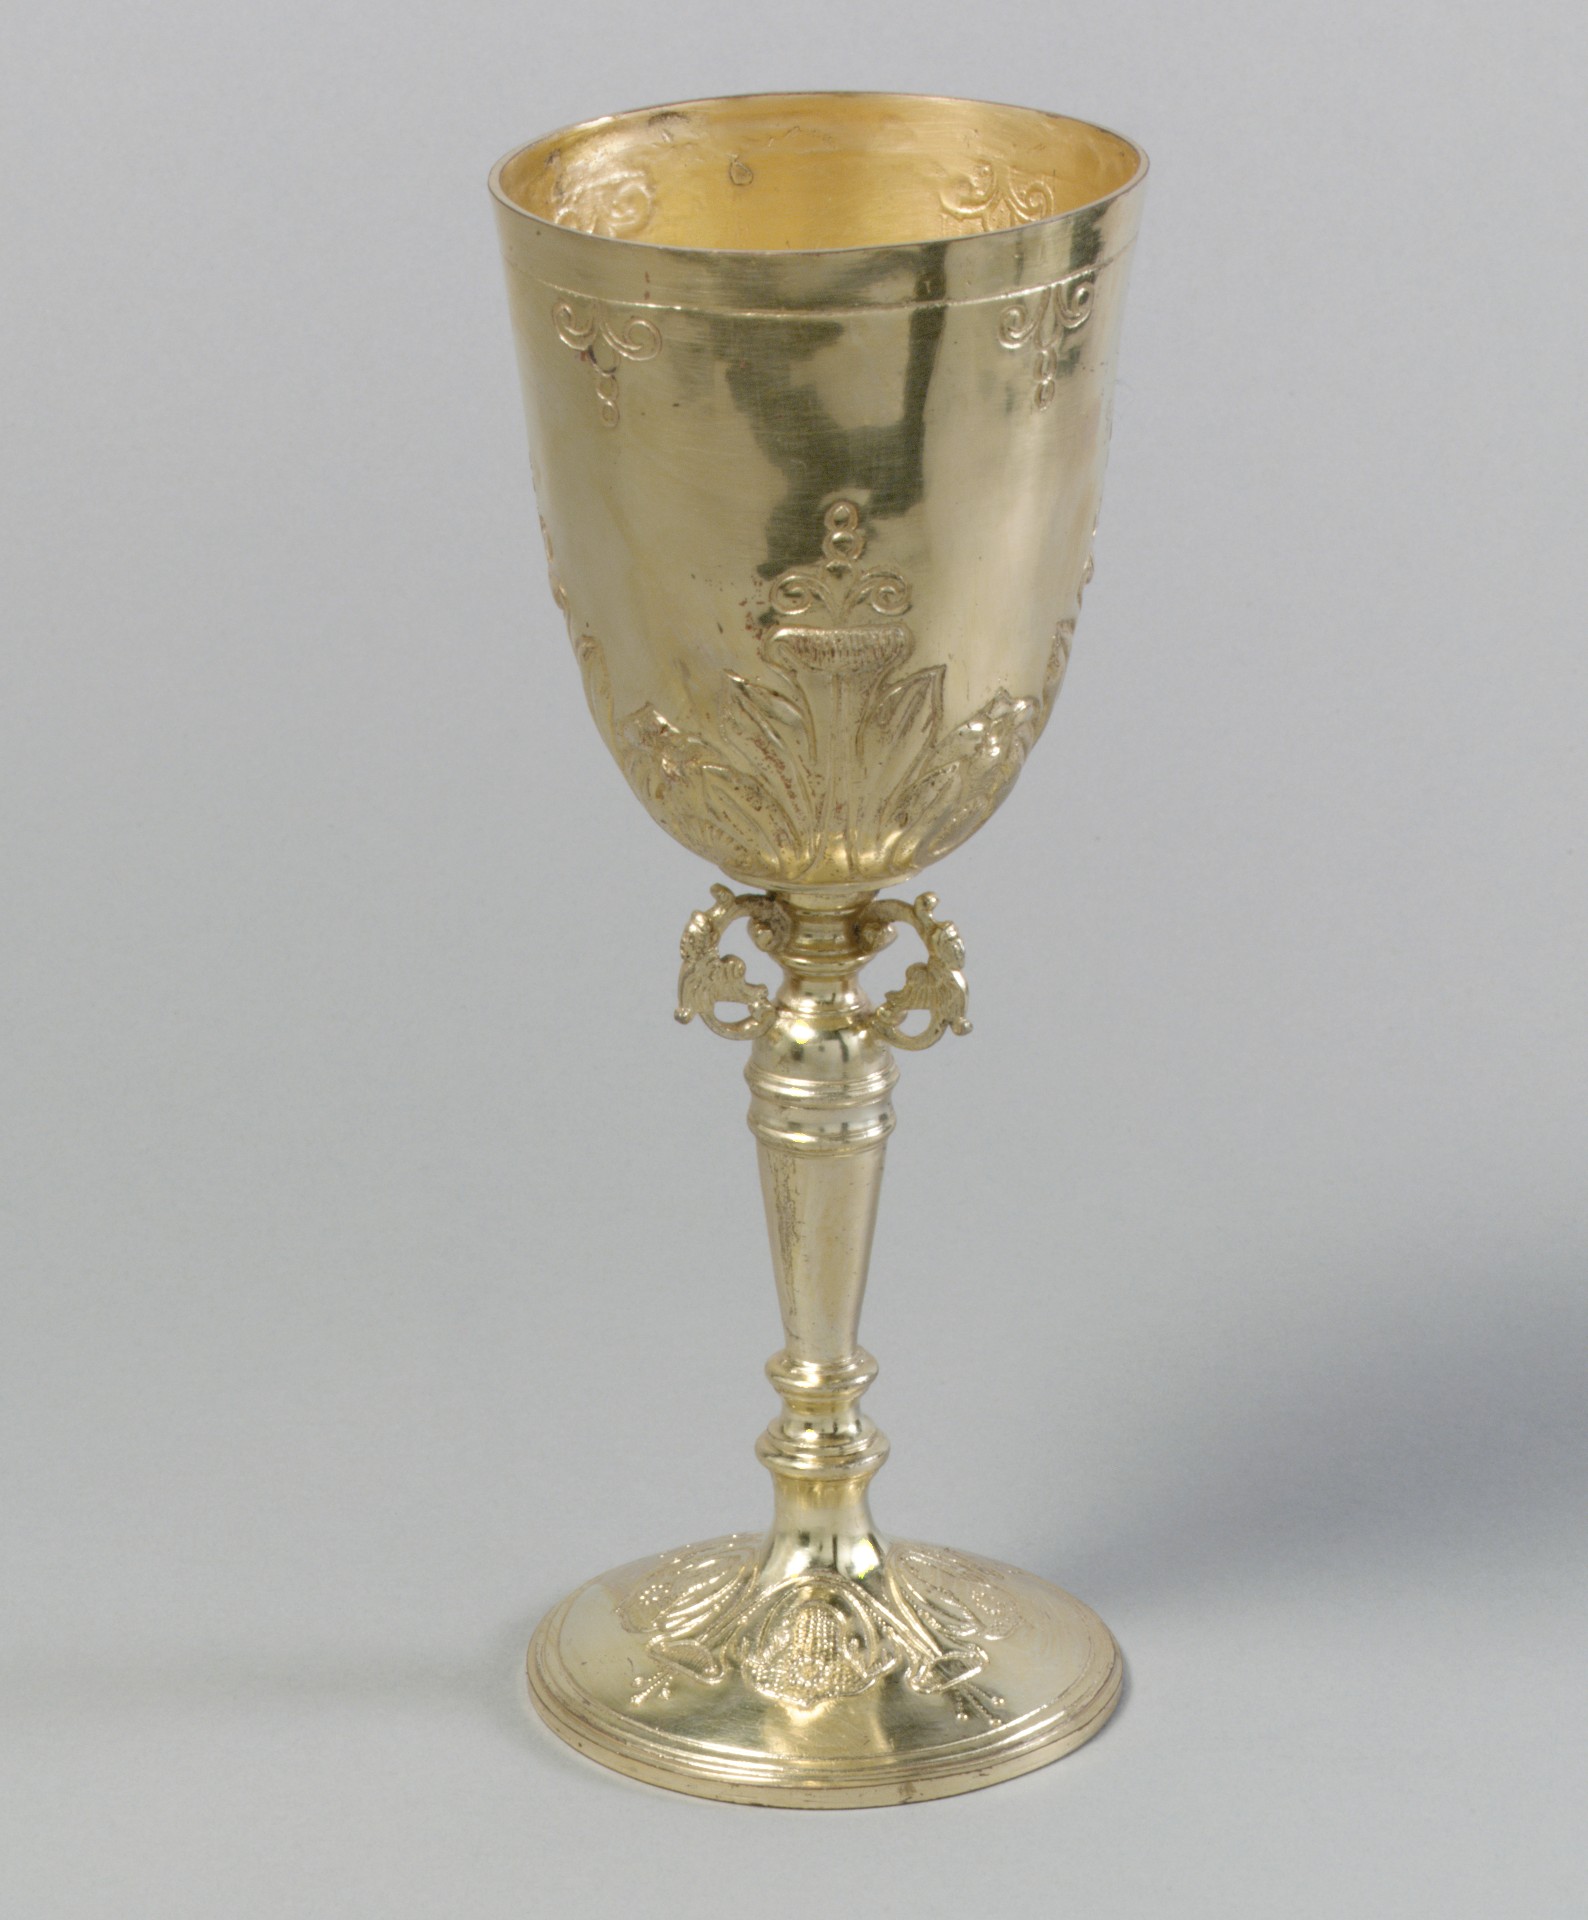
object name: cup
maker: elkington & co.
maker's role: manufacturer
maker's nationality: british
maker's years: 1829-1963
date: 1801-1900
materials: metal, silver